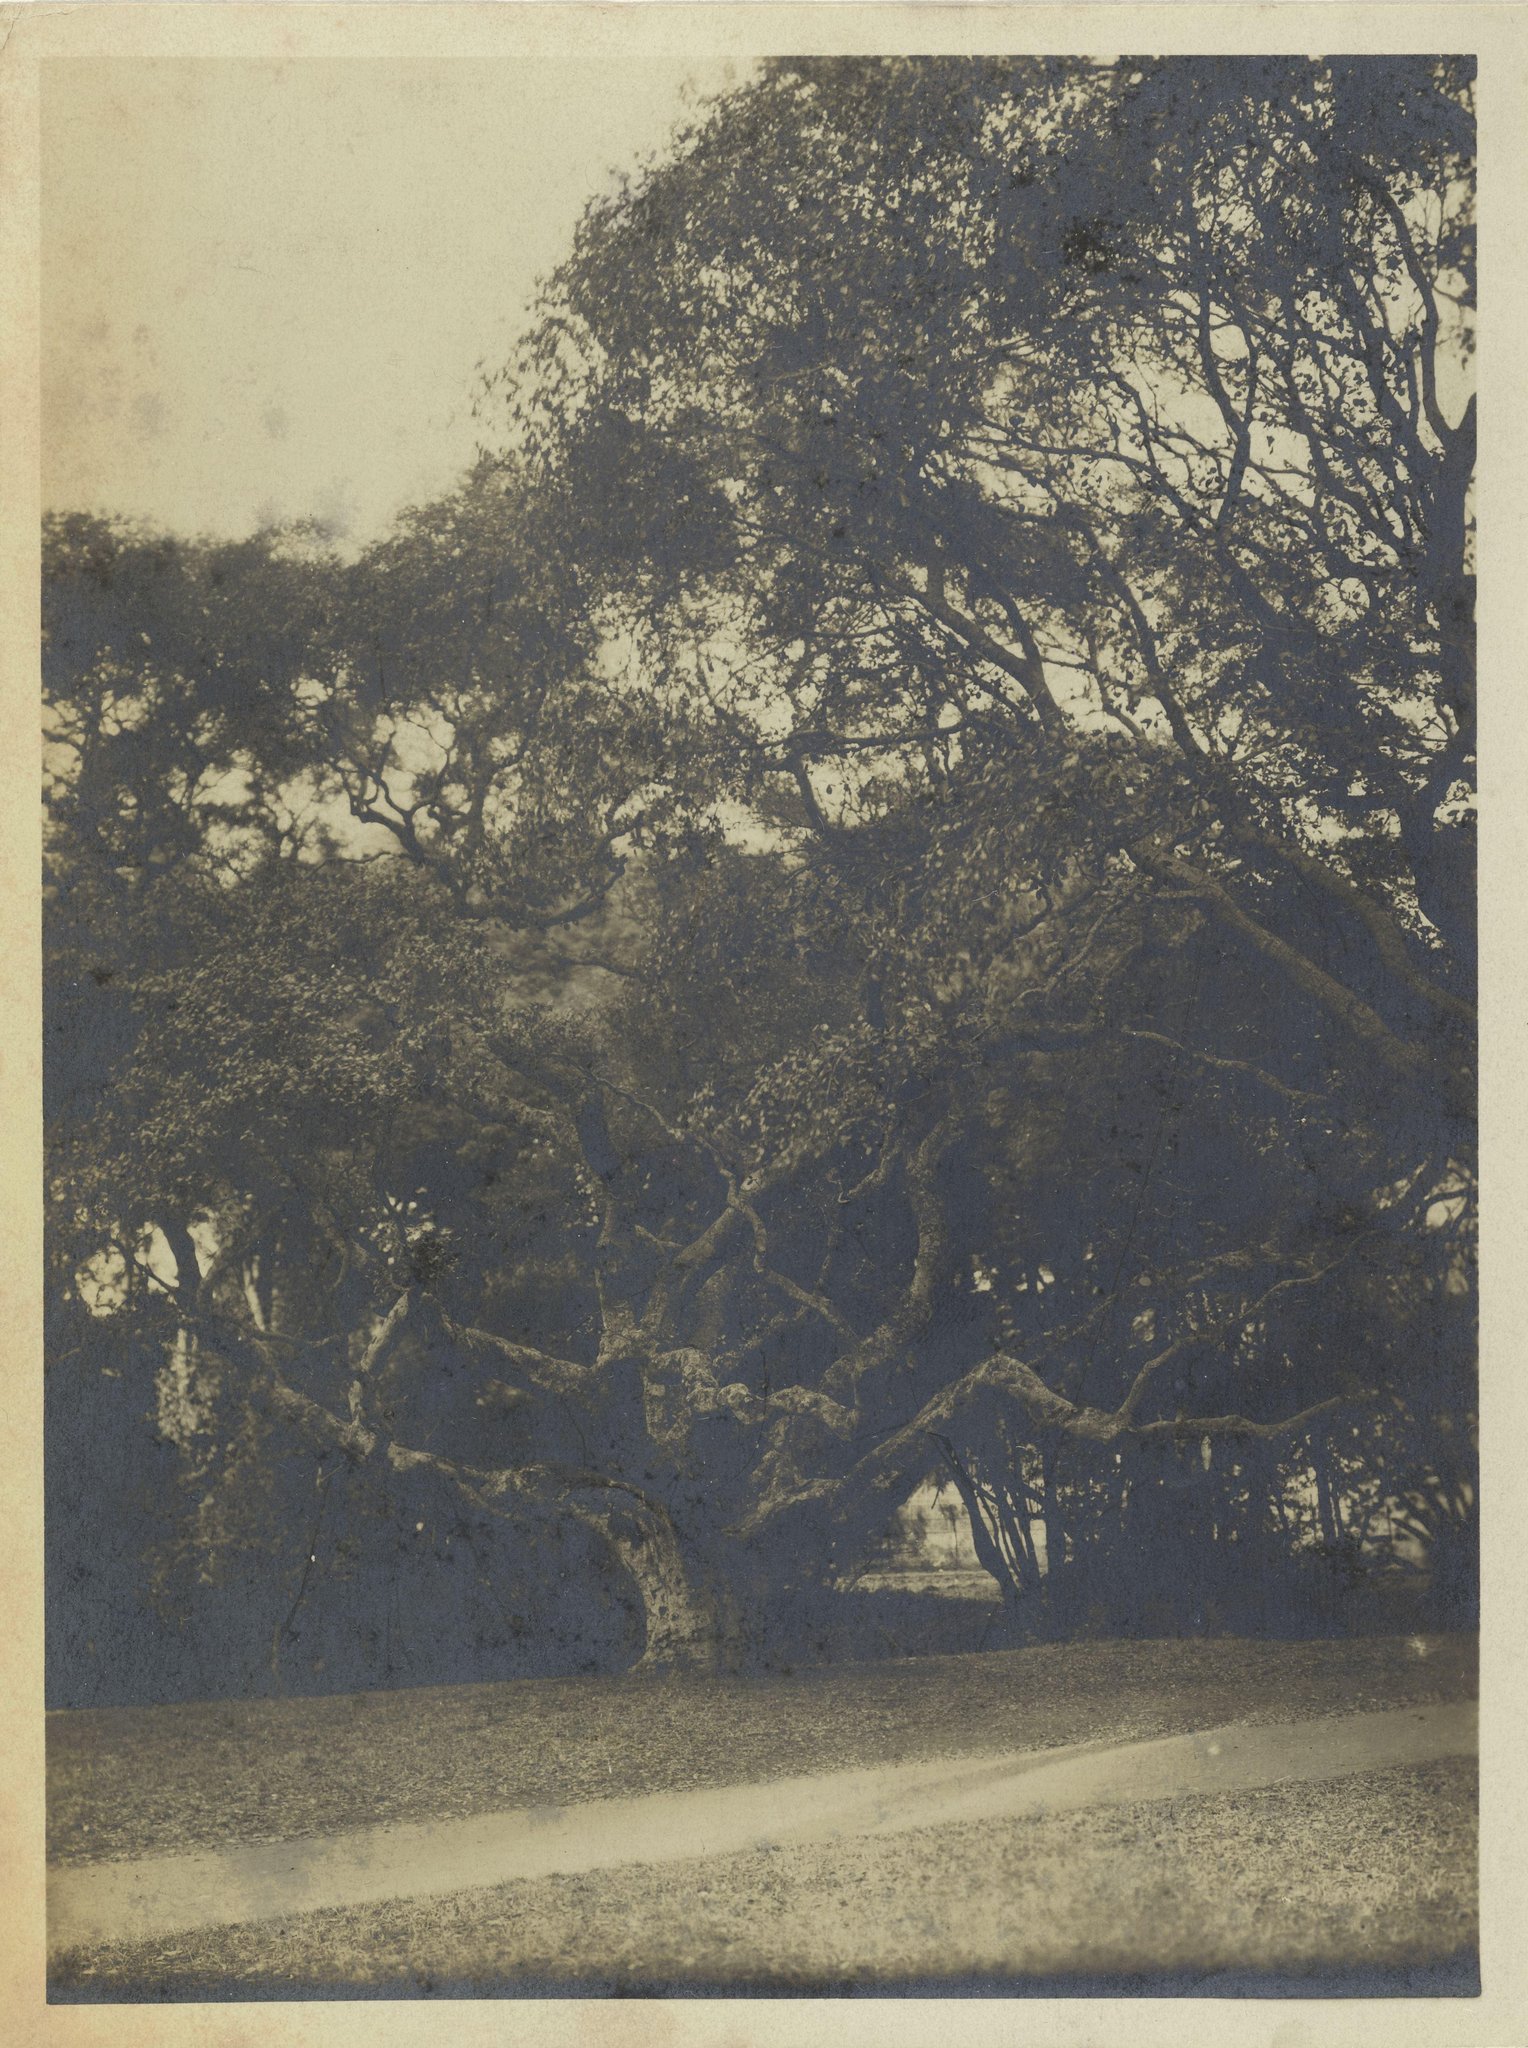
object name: photograph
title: Bomen in Yosemite National Park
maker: Anonymous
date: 1900-1920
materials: paper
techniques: gelatin silver print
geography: yosemite national park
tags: trees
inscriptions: inscription: ‘yosemite’